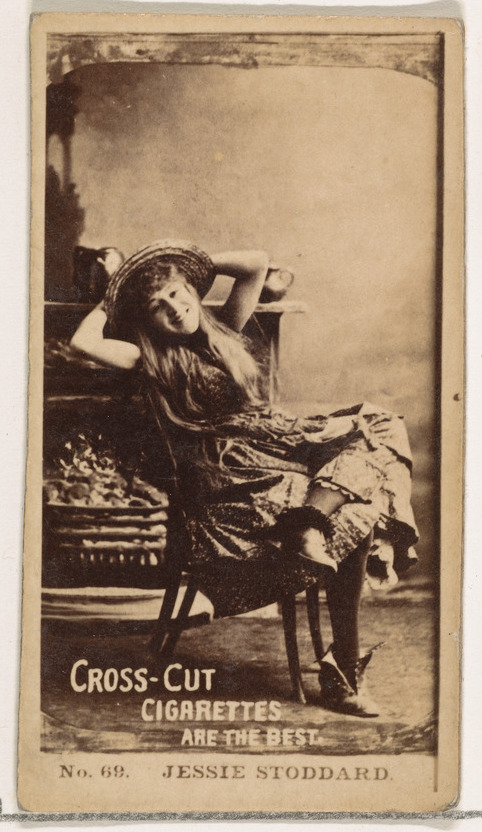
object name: print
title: Card Number 69, Jessie Stoddard, from the Actors and Actresses series (N145-2) issued by Duke Sons & Co. to promote Cross Cut Cigarettes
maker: w. duke, sons & co.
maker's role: publisher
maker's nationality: american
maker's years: 1870-1920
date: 1880-1889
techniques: albumen silver print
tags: portraits,women,actresses